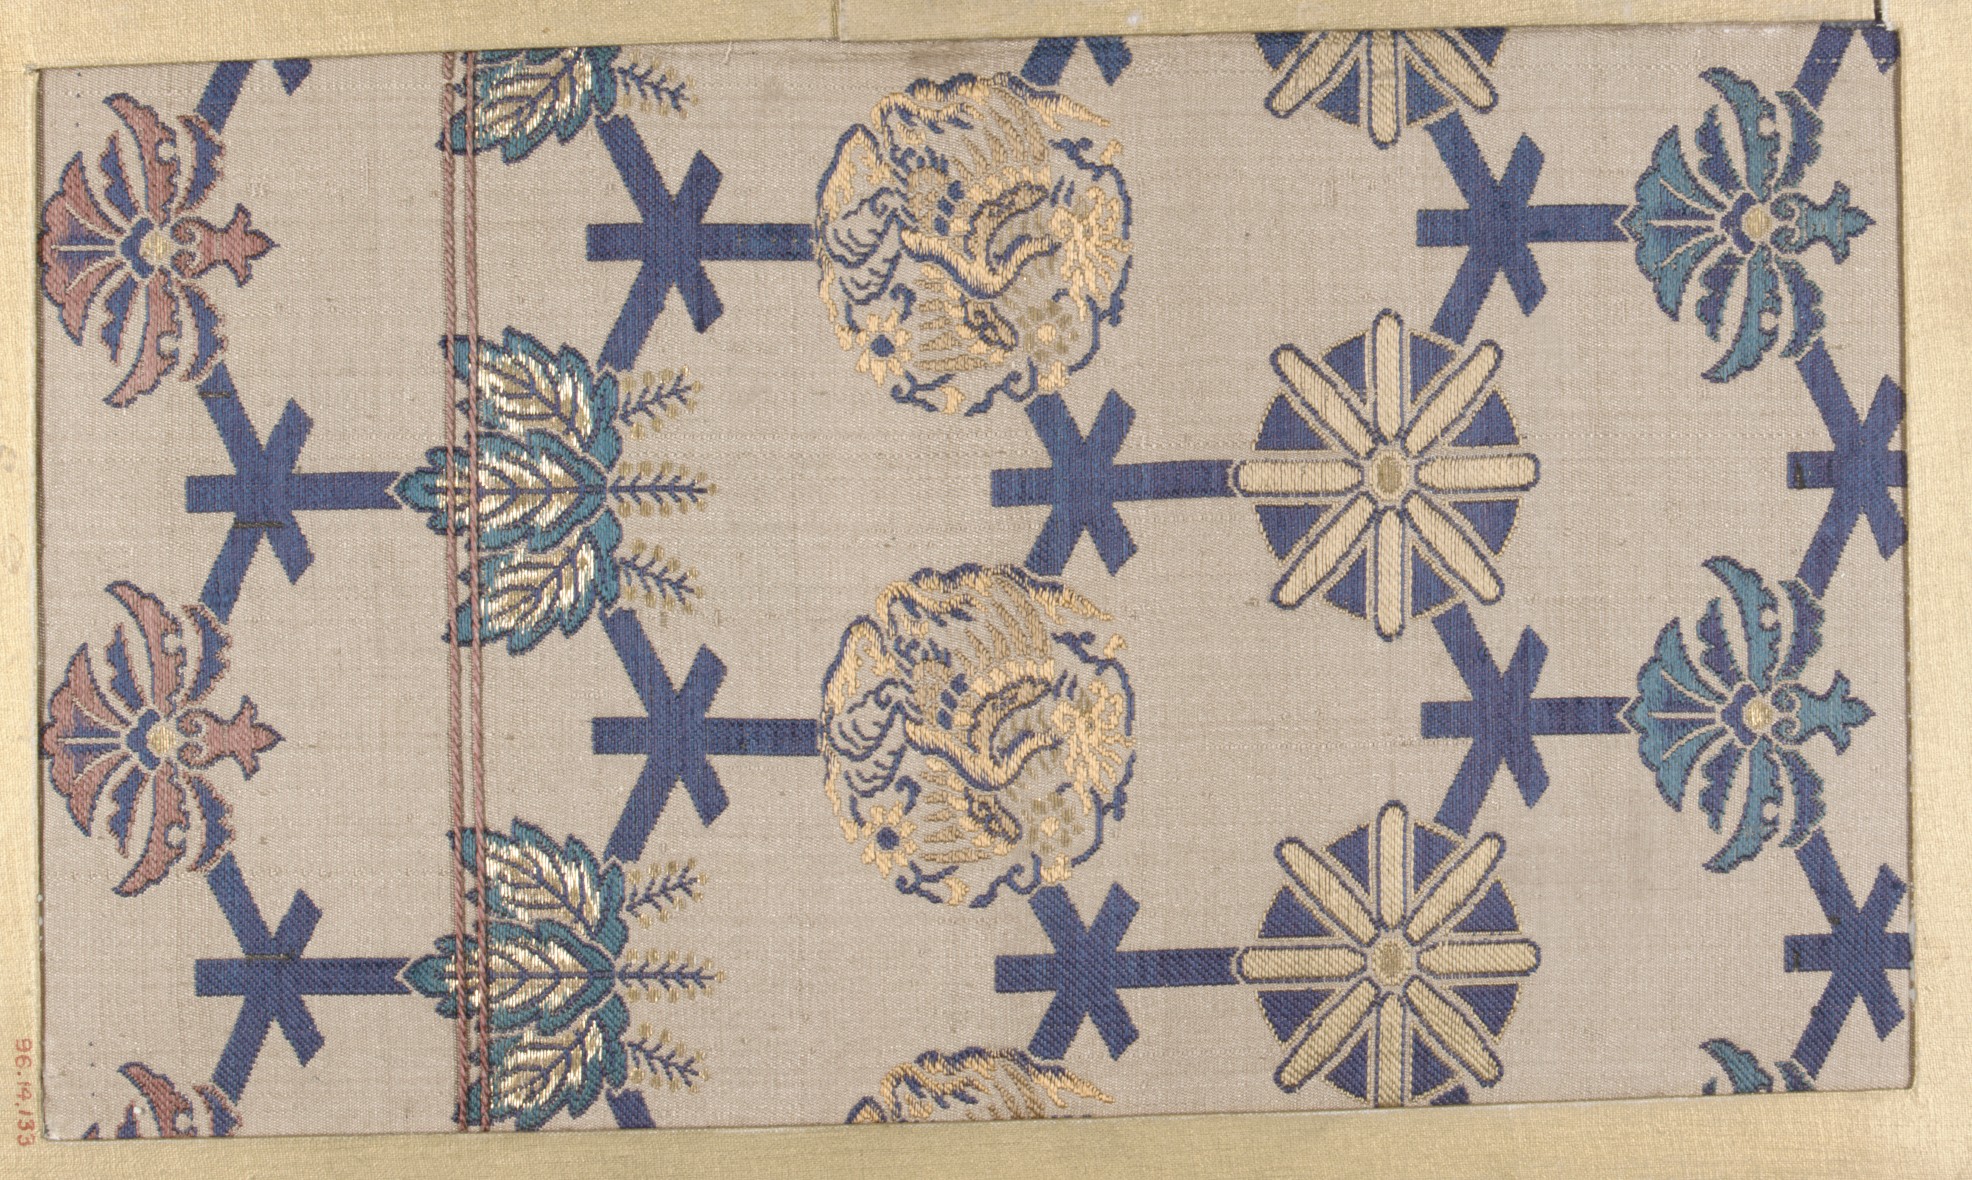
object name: piece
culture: japanese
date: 1701-1900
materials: silk